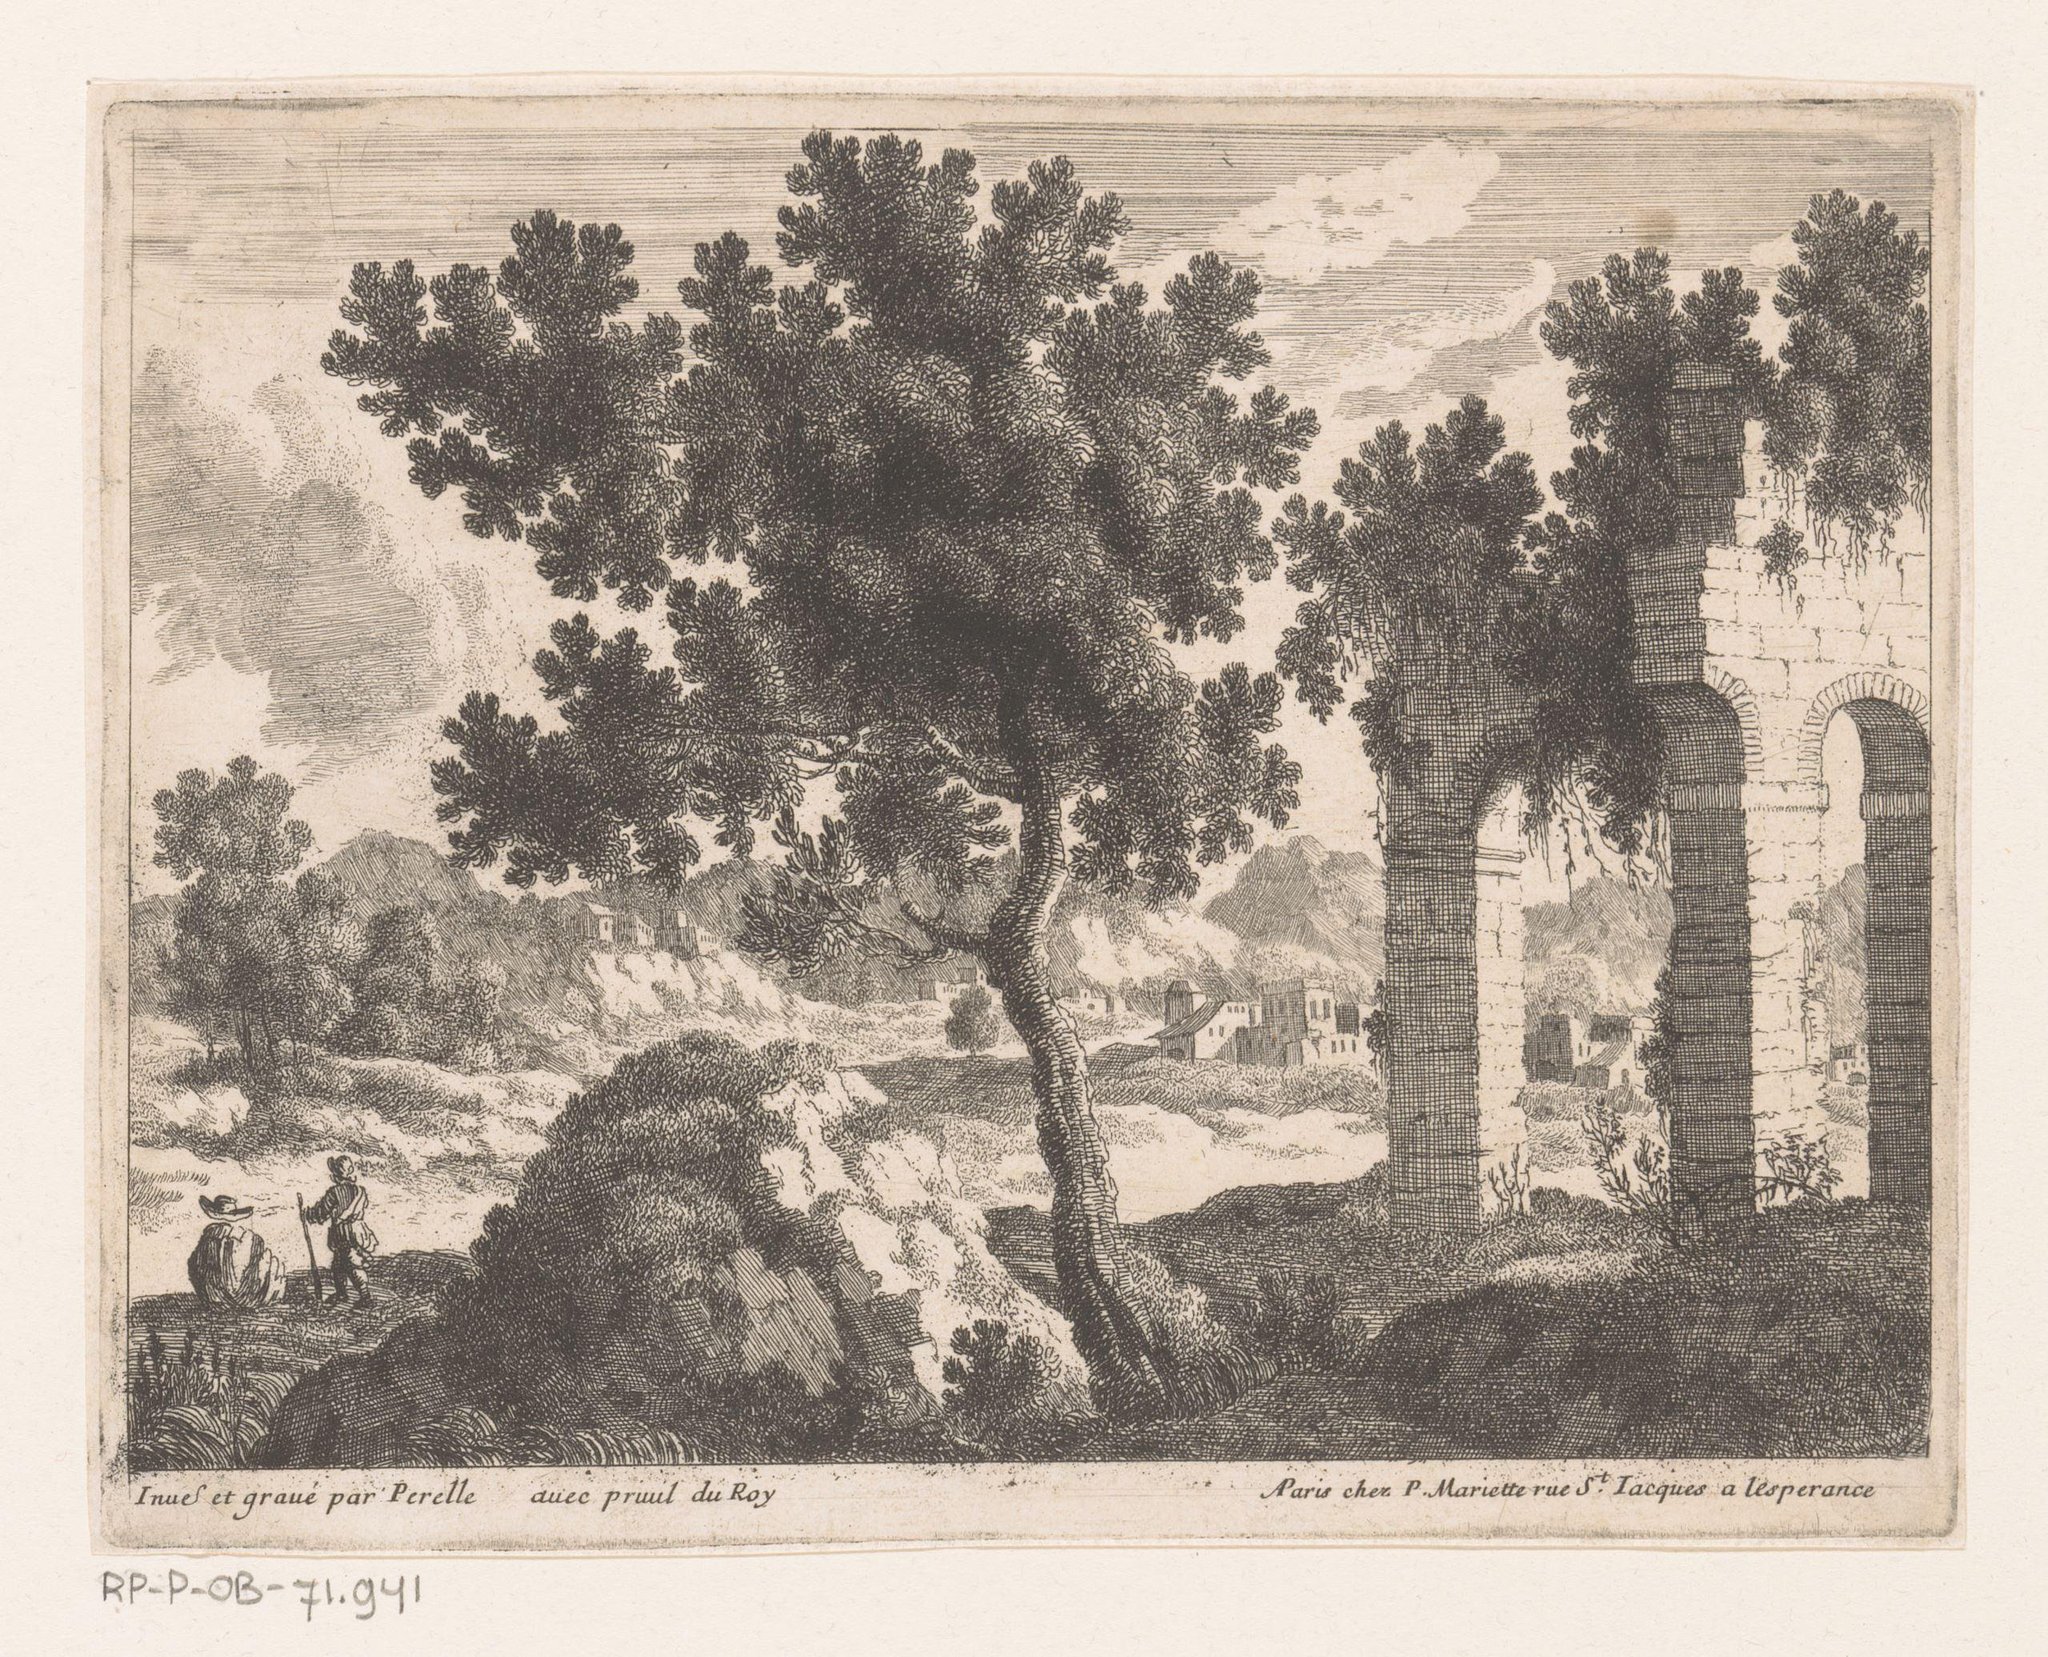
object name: print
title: Landschap met ruïne met bogen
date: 1613-1695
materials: paper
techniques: etching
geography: france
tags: landscape with ruins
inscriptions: collector's mark: Lugt 240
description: Prenten met het signatuur 'Perelle' kunnen zowel door vader Gabriel als door zonen Nicolas en Adam gemaakt zijn.